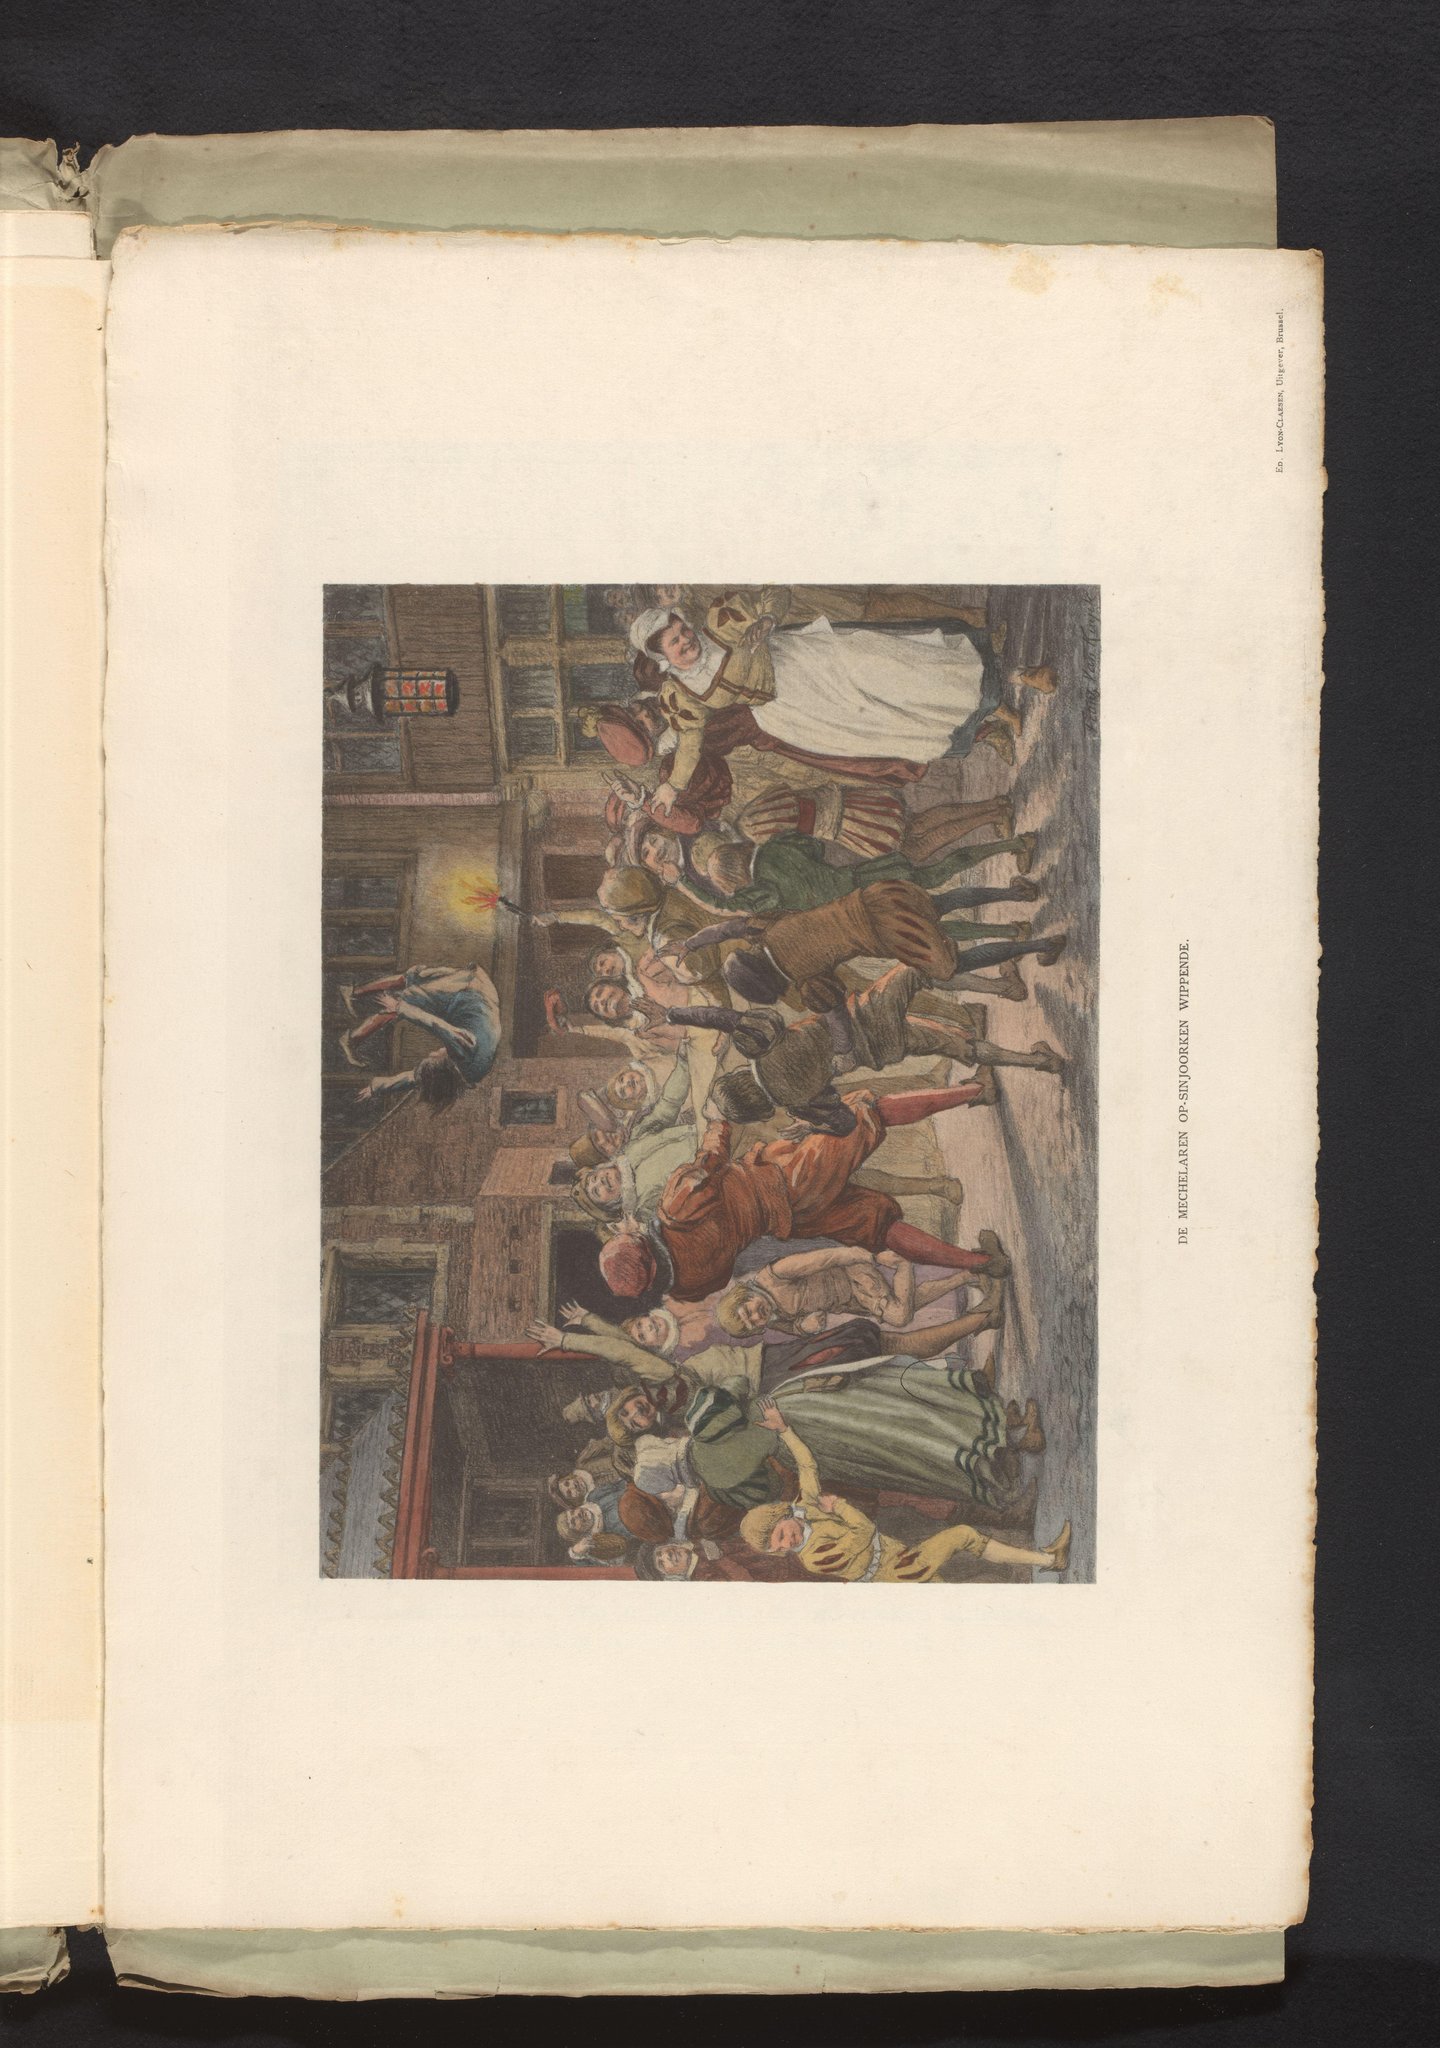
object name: page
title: De Mechelen Op-sinjoorken Wippende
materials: paper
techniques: photograph, lithograph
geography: brussels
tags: world fair, world exhibition, swinging (children's game), antwerp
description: Prent op los blad tussen pagina 38 en 39.